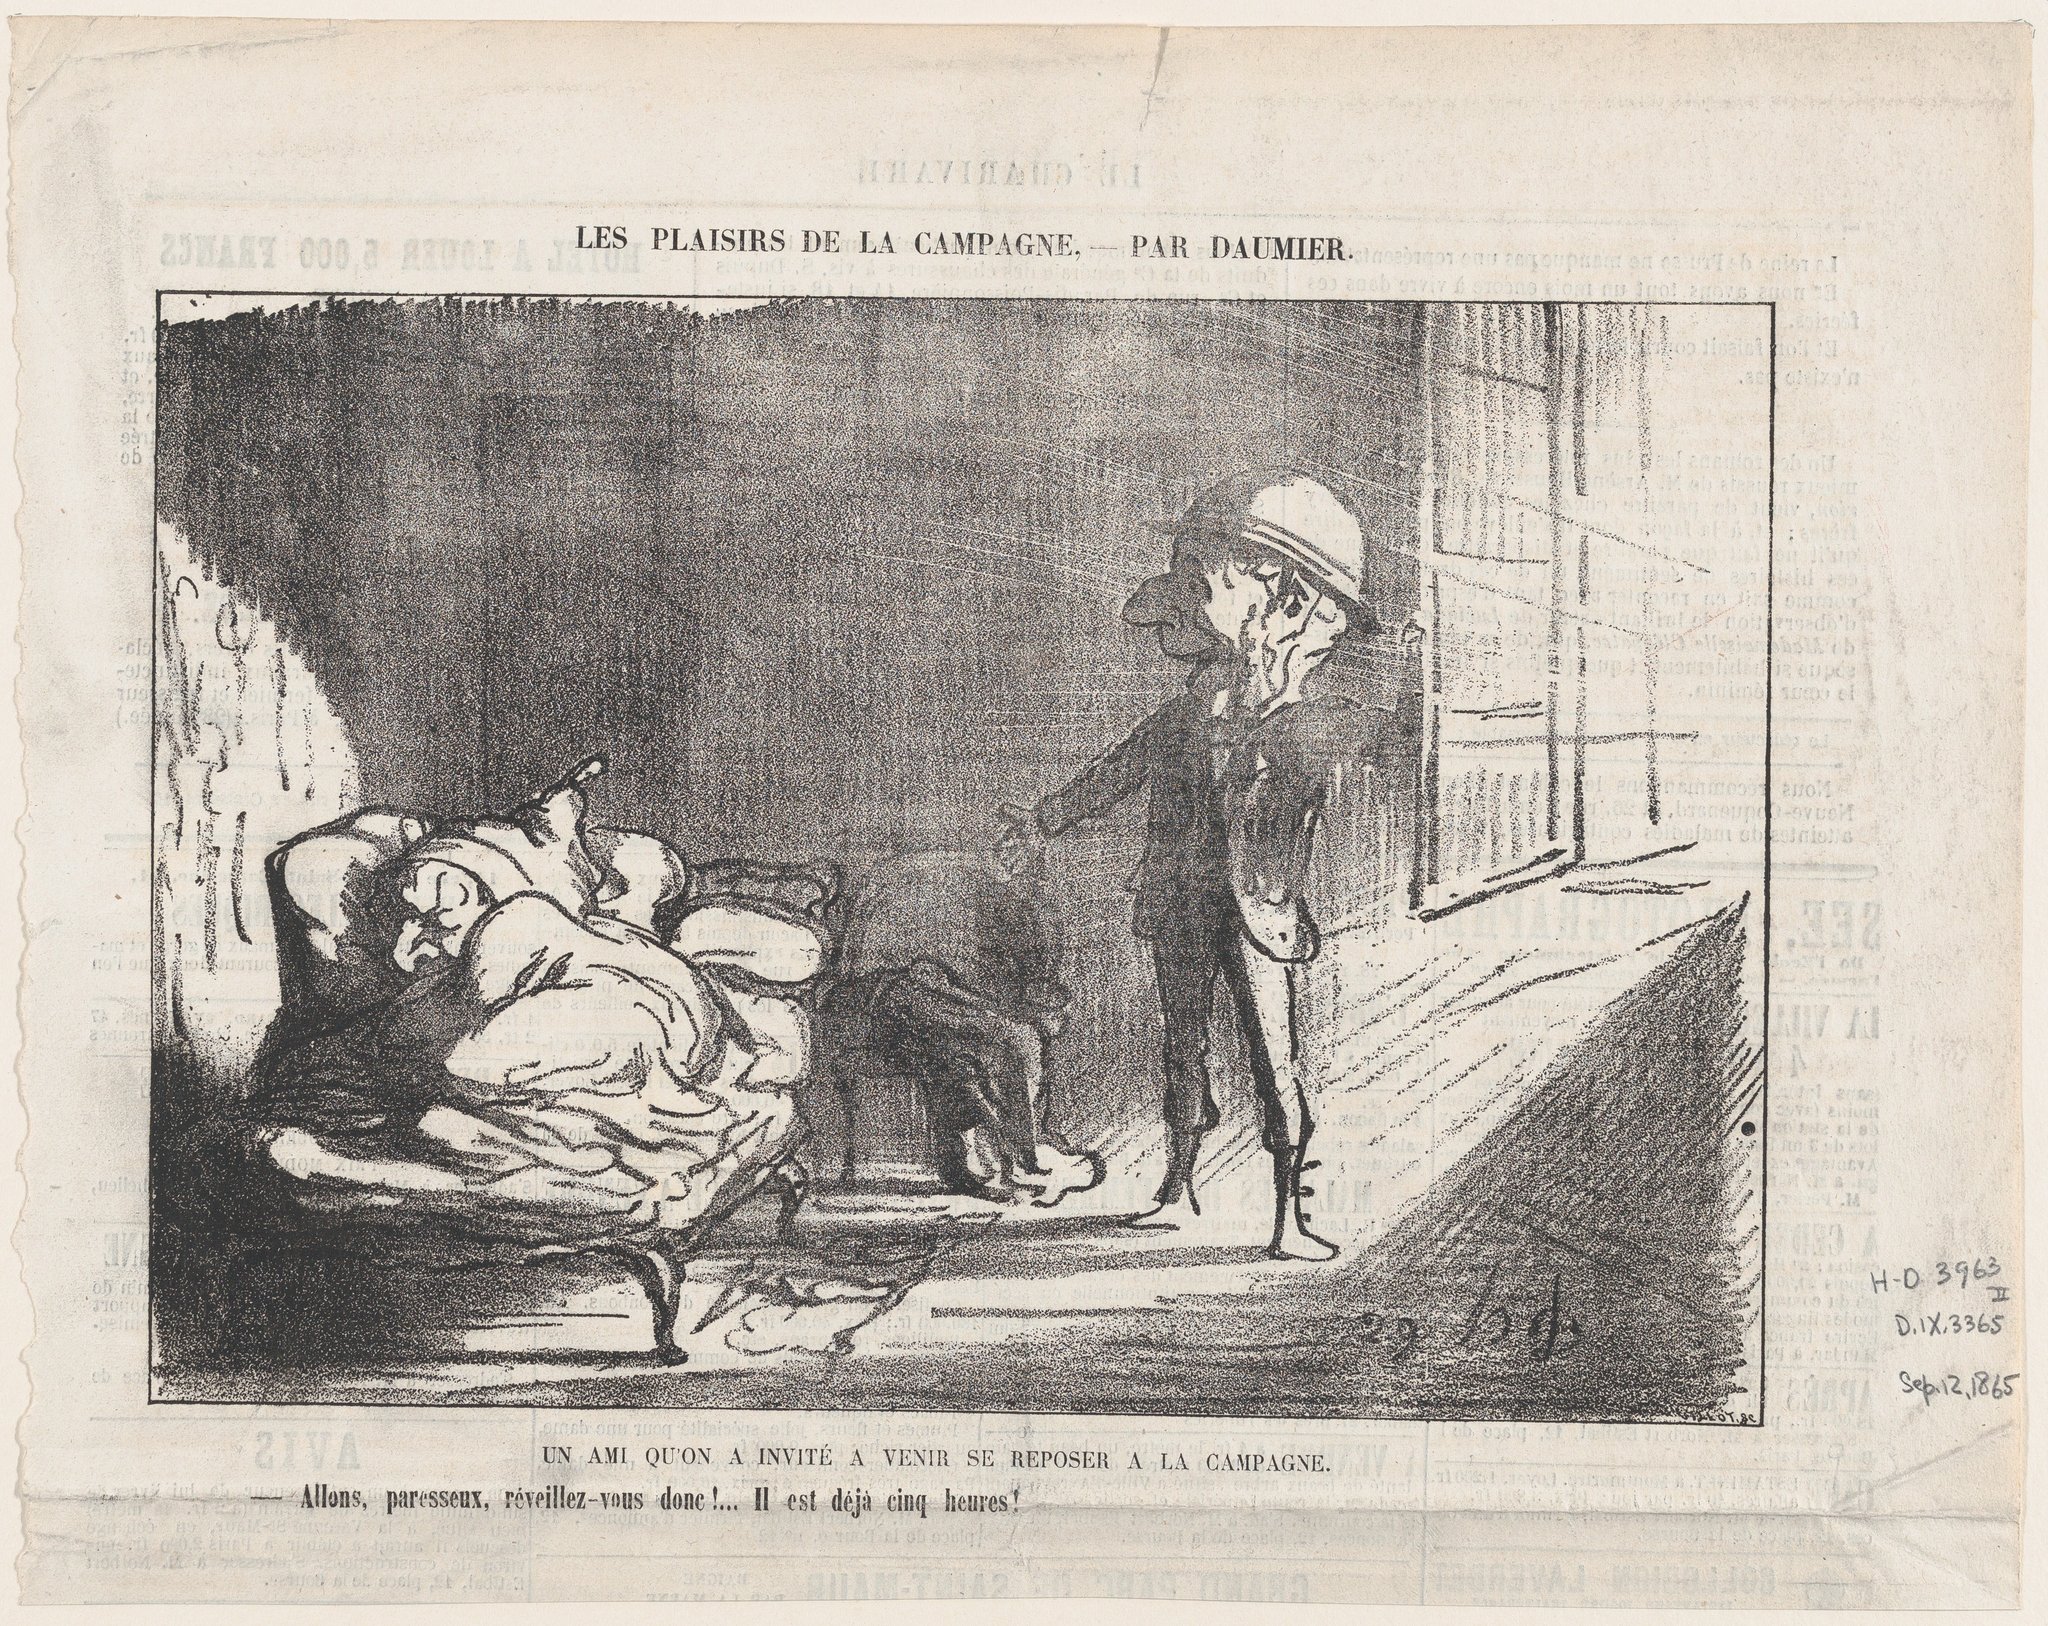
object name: print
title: A friend who was invited to relax for a few days in the countryside, from 'The joys of country life,' published in Le Charivari, September 12, 1865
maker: honoré daumier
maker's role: artist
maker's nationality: french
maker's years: 1808-1879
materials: paper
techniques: lithograph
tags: sleeping,men